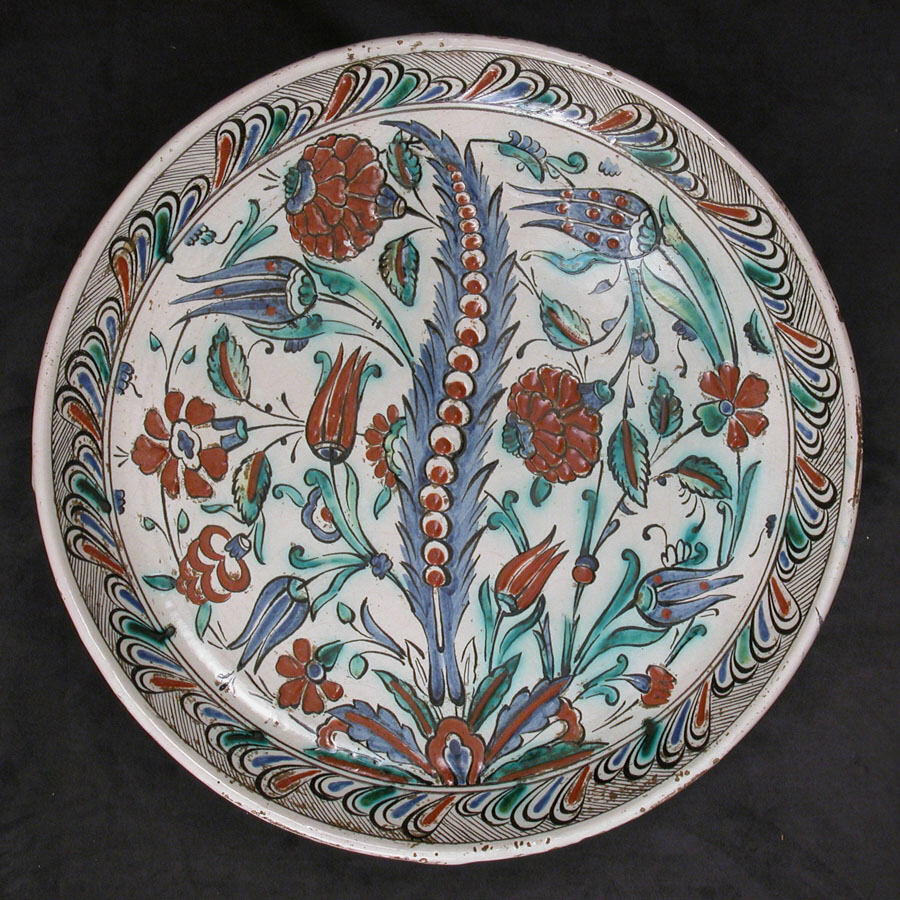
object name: plate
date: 1501-1700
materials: glaze, stonepaste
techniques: painting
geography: turkey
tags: flowers,leaves